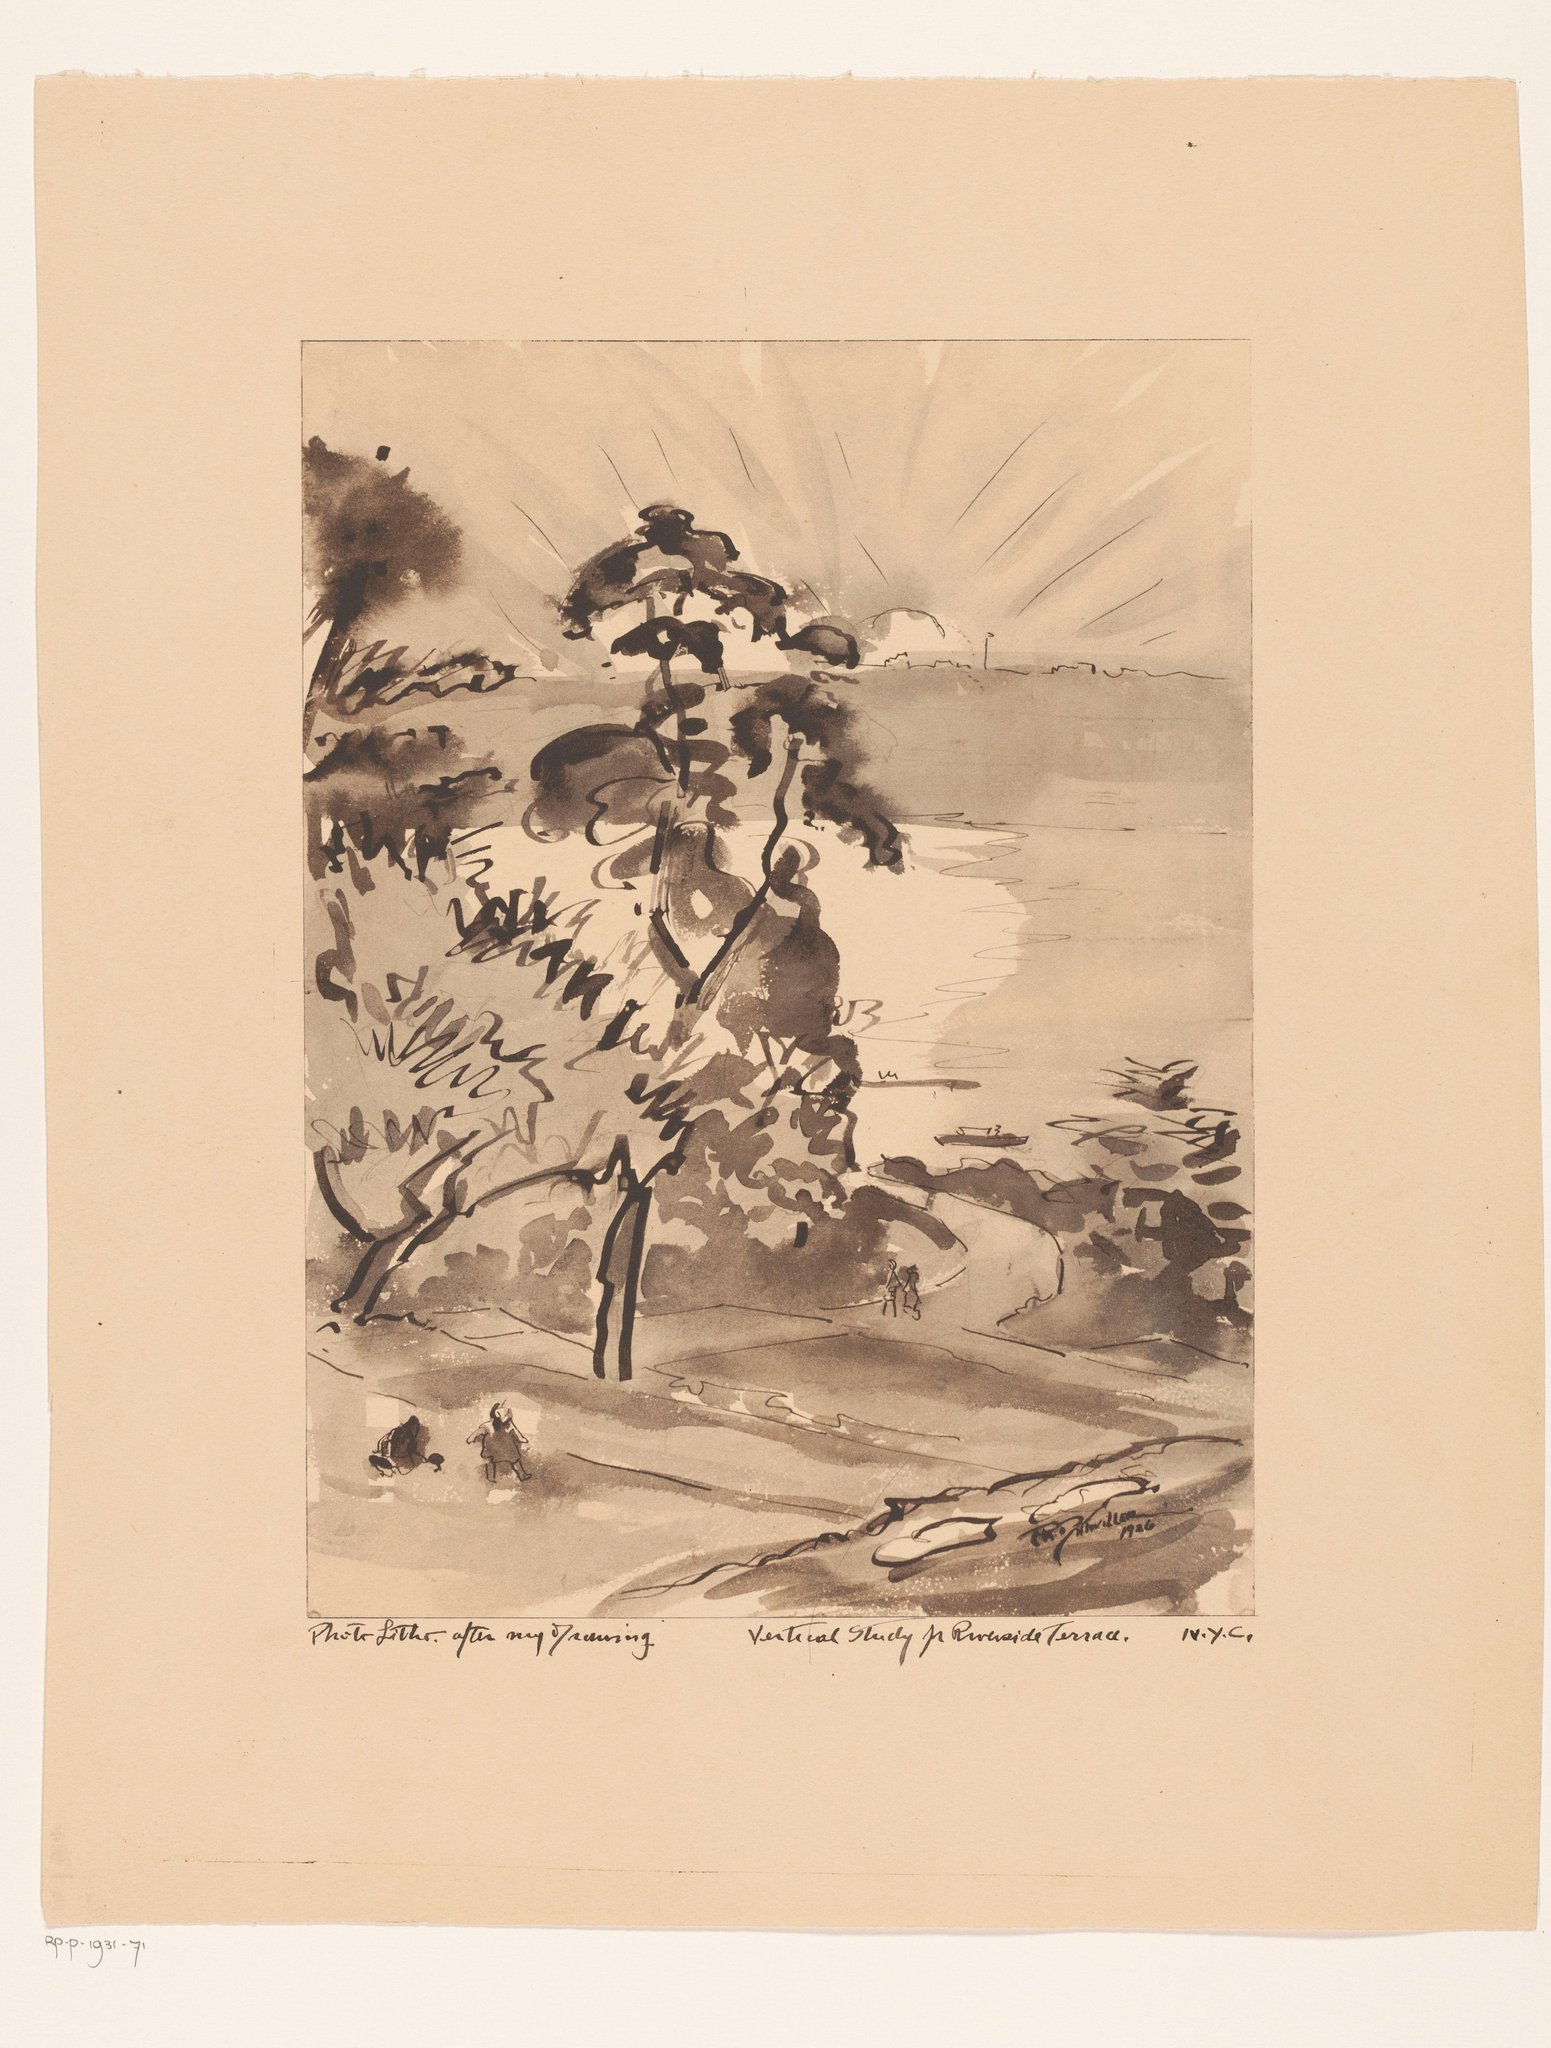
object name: photomechanical print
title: Vertical Study for Riverside Terrace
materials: paper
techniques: photolithography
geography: new york city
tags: river, landscapes in the temperate zone, sunset, new york (city)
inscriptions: collector's mark: Lugt 2228, annotation: ‘P.C #154’